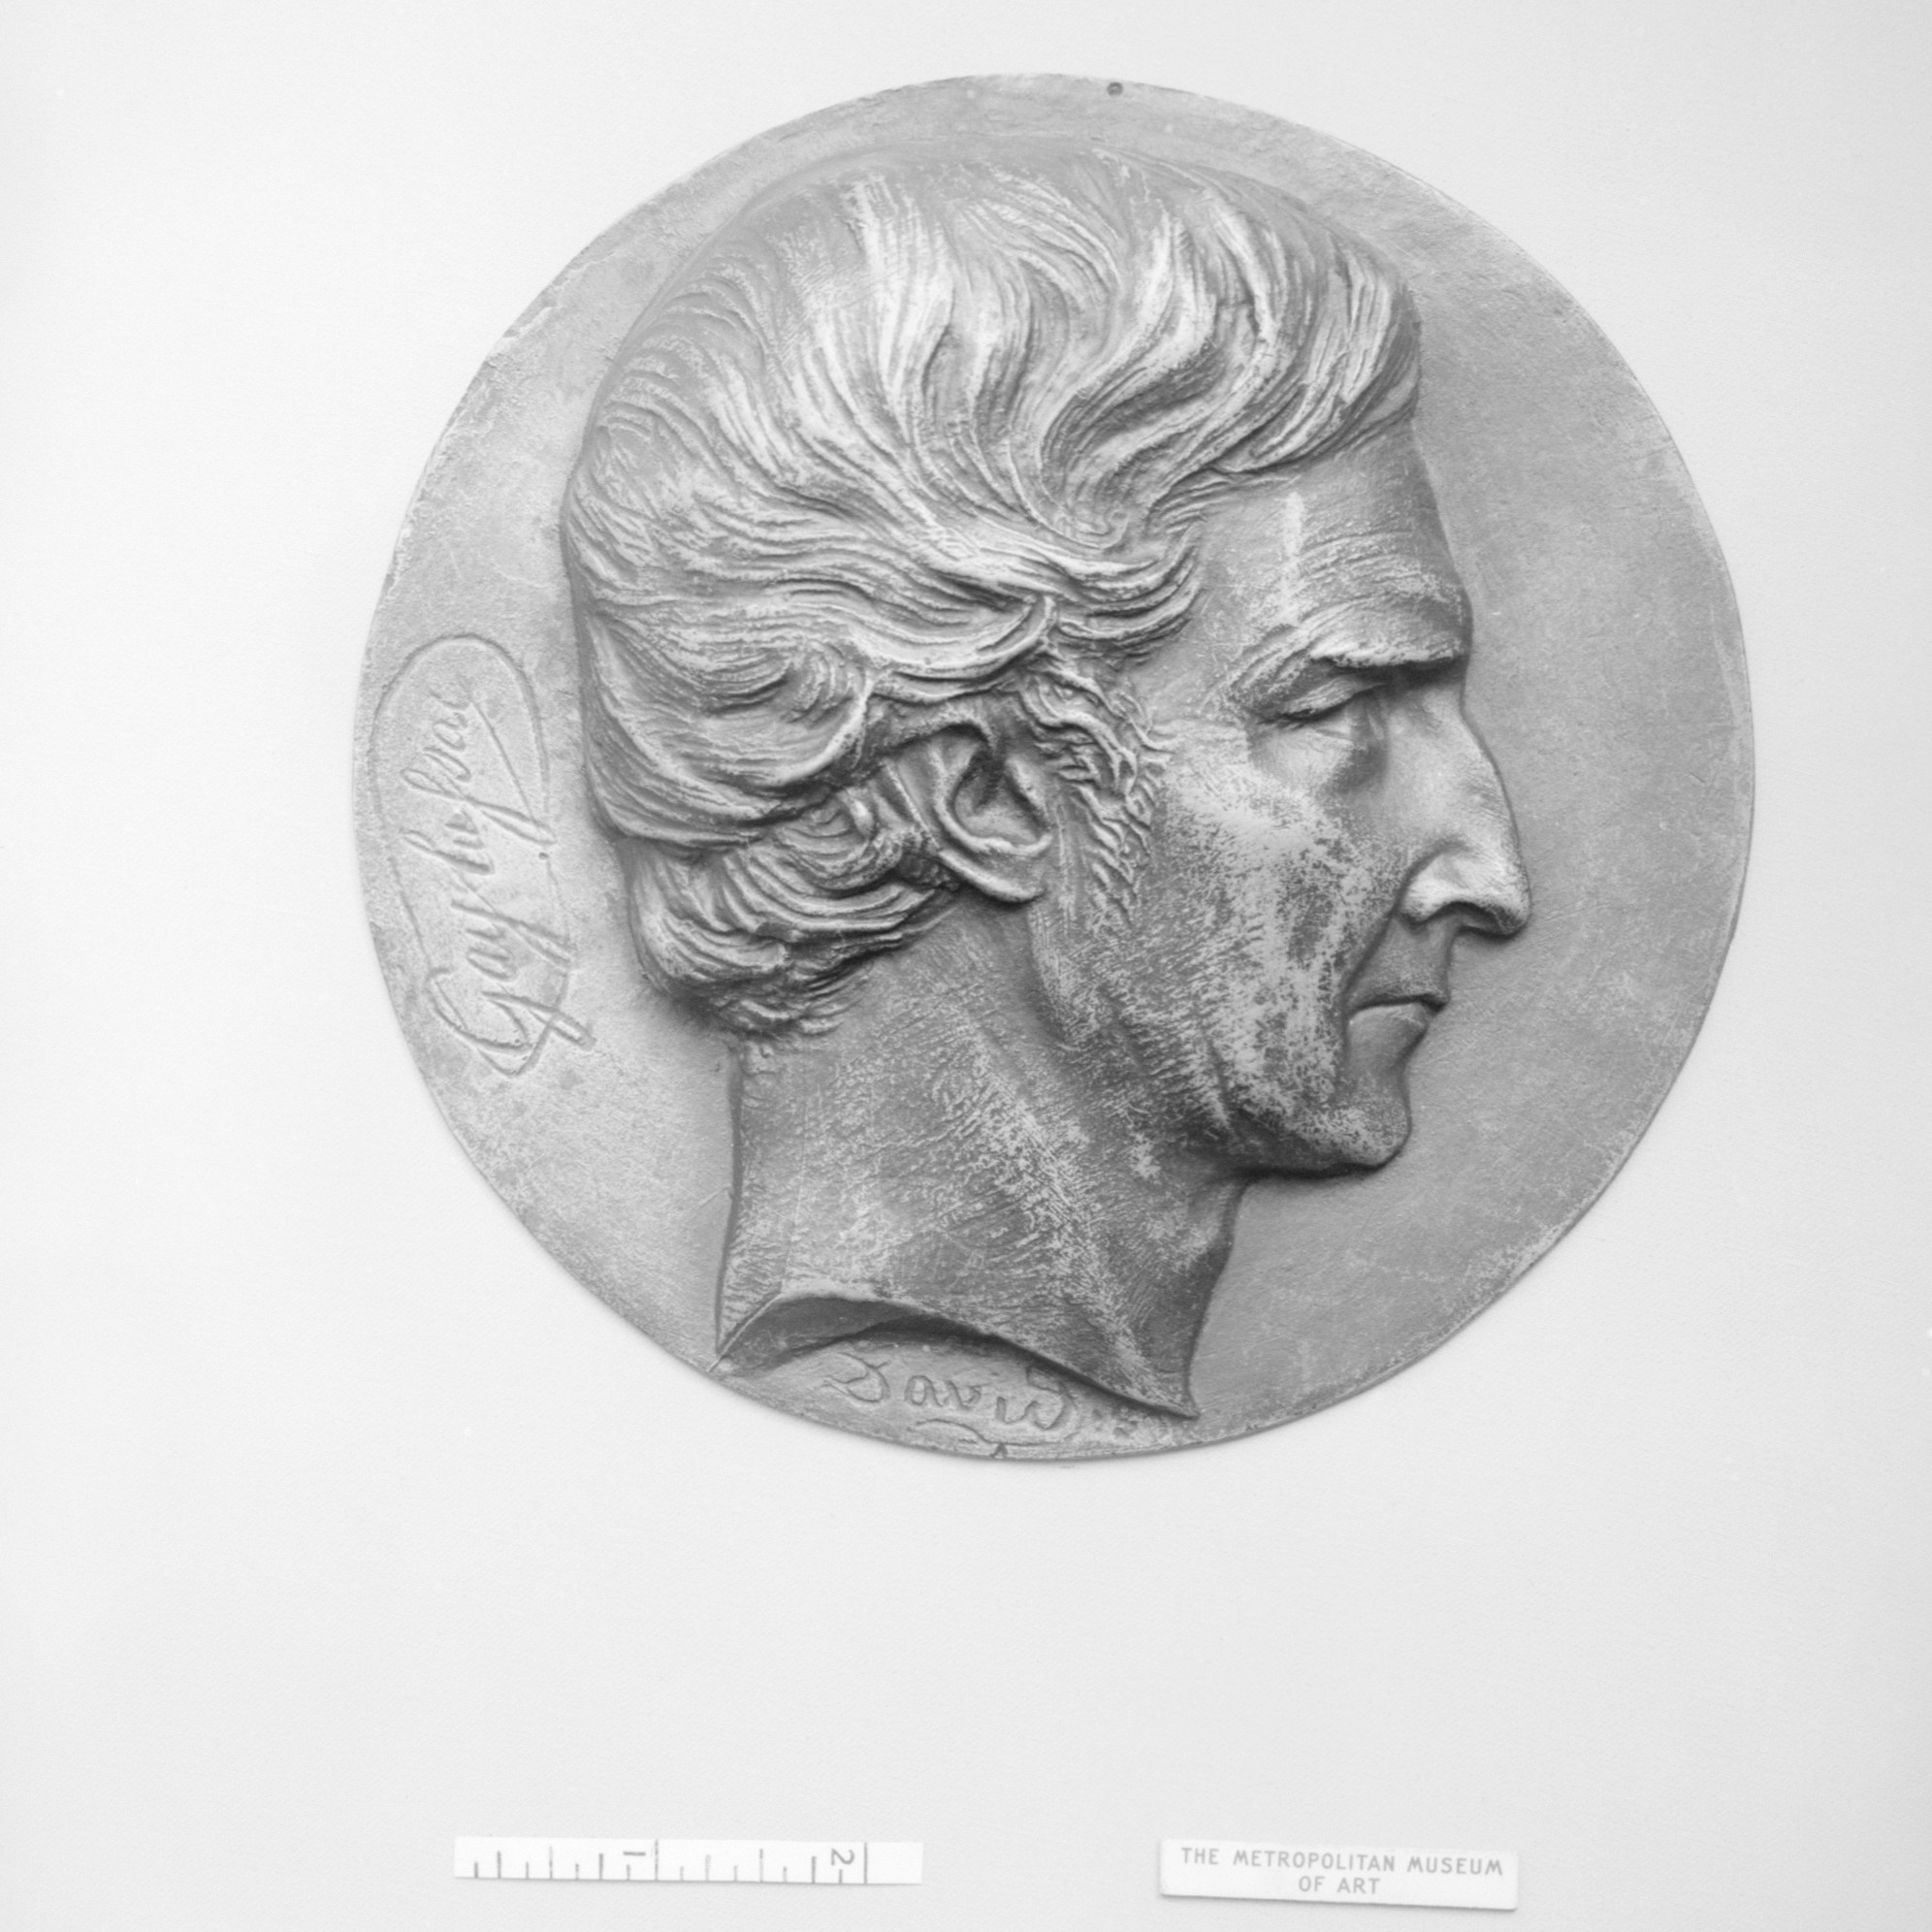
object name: medallion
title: Joseph Louis Gay-Lussac, French physician and scientist (1778–1850)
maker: pierre jean david d'angers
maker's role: artist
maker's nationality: french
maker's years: 1788-1856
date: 1830-1839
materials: bronze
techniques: casting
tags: men,profiles